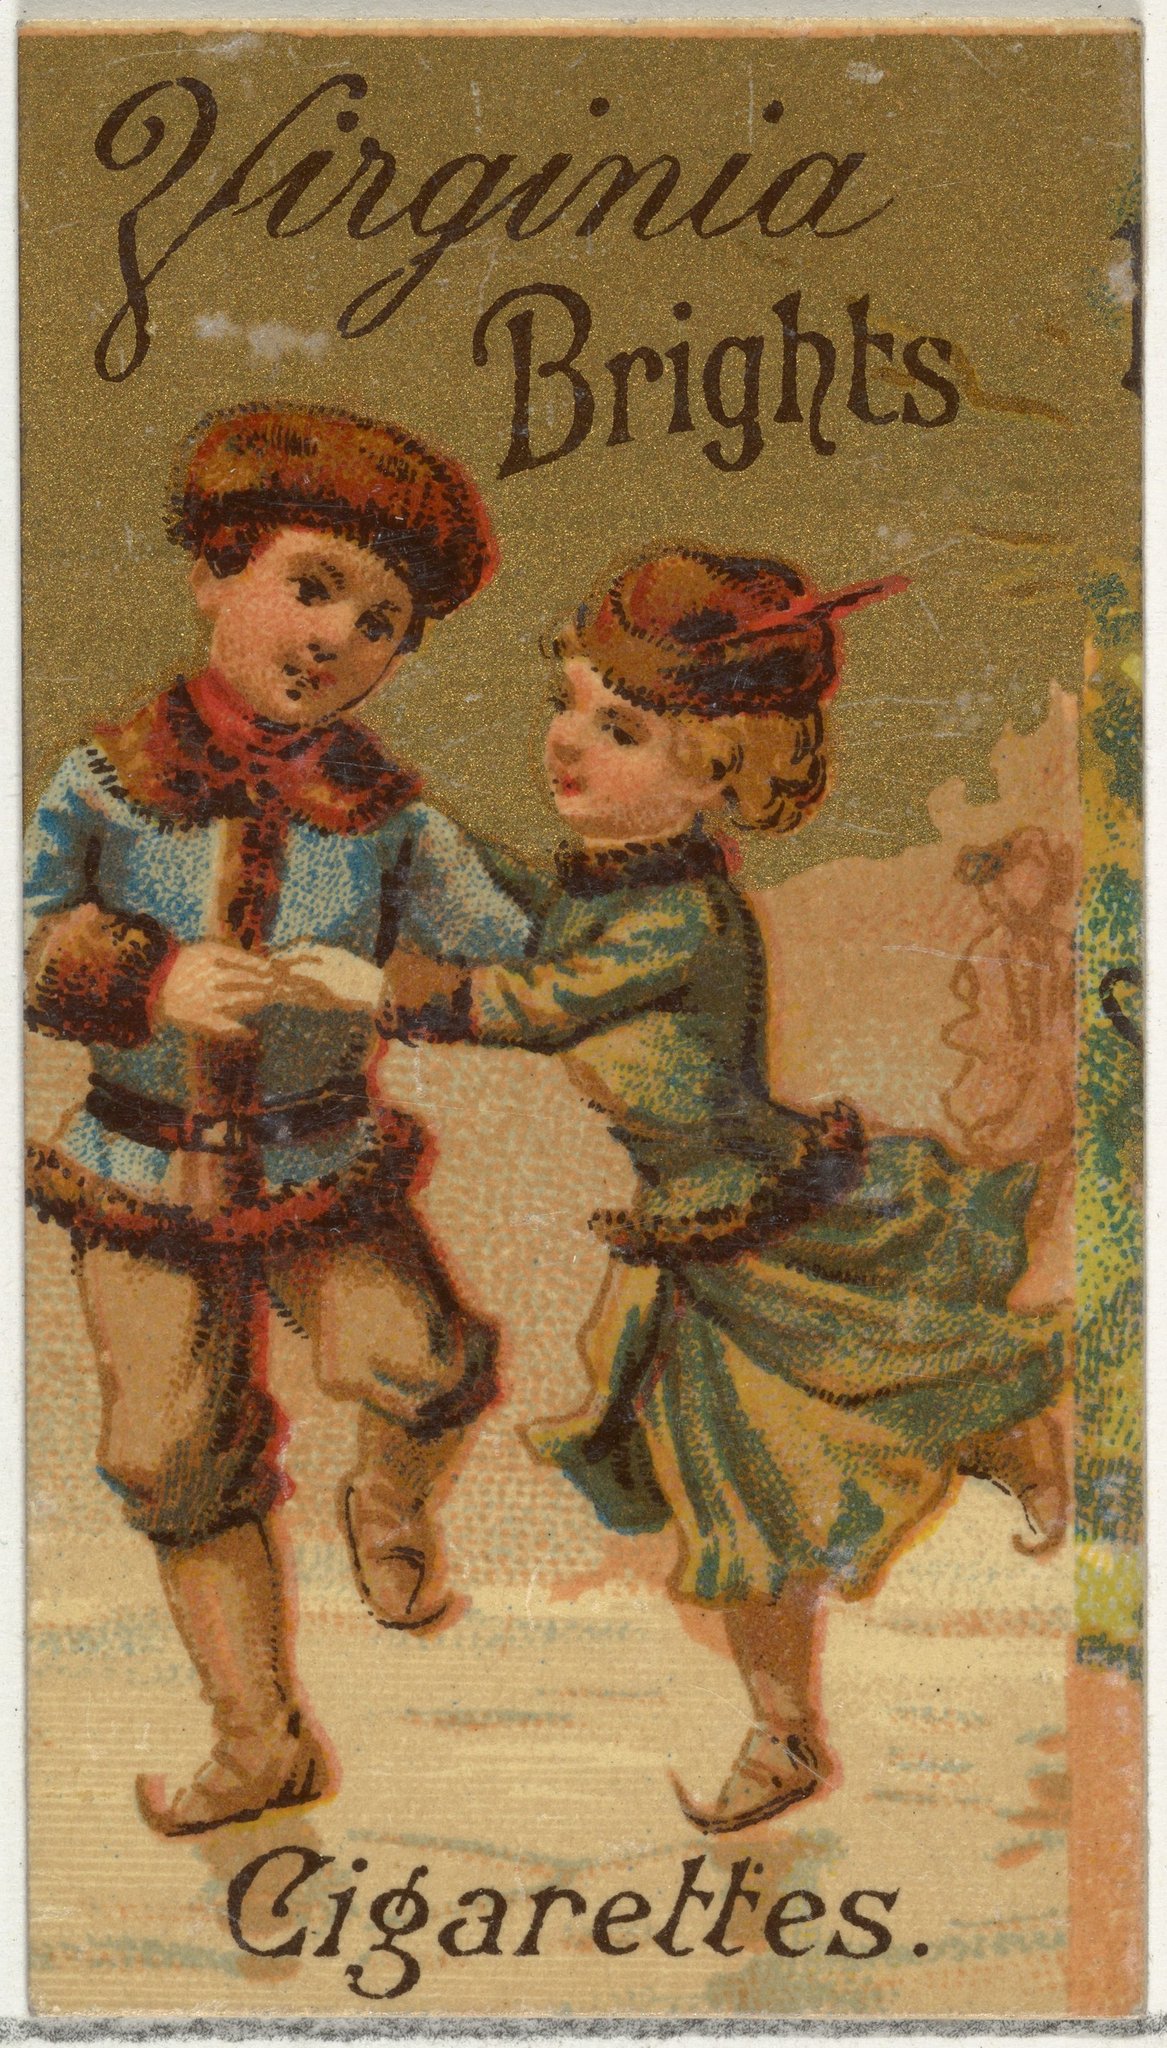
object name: print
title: From the Girls and Children series (N64) promoting Virginia Brights Cigarettes for Allen & Ginter brand tobacco products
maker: allen & ginter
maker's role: publisher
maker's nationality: american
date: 1886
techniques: color lithograph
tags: boys,girls